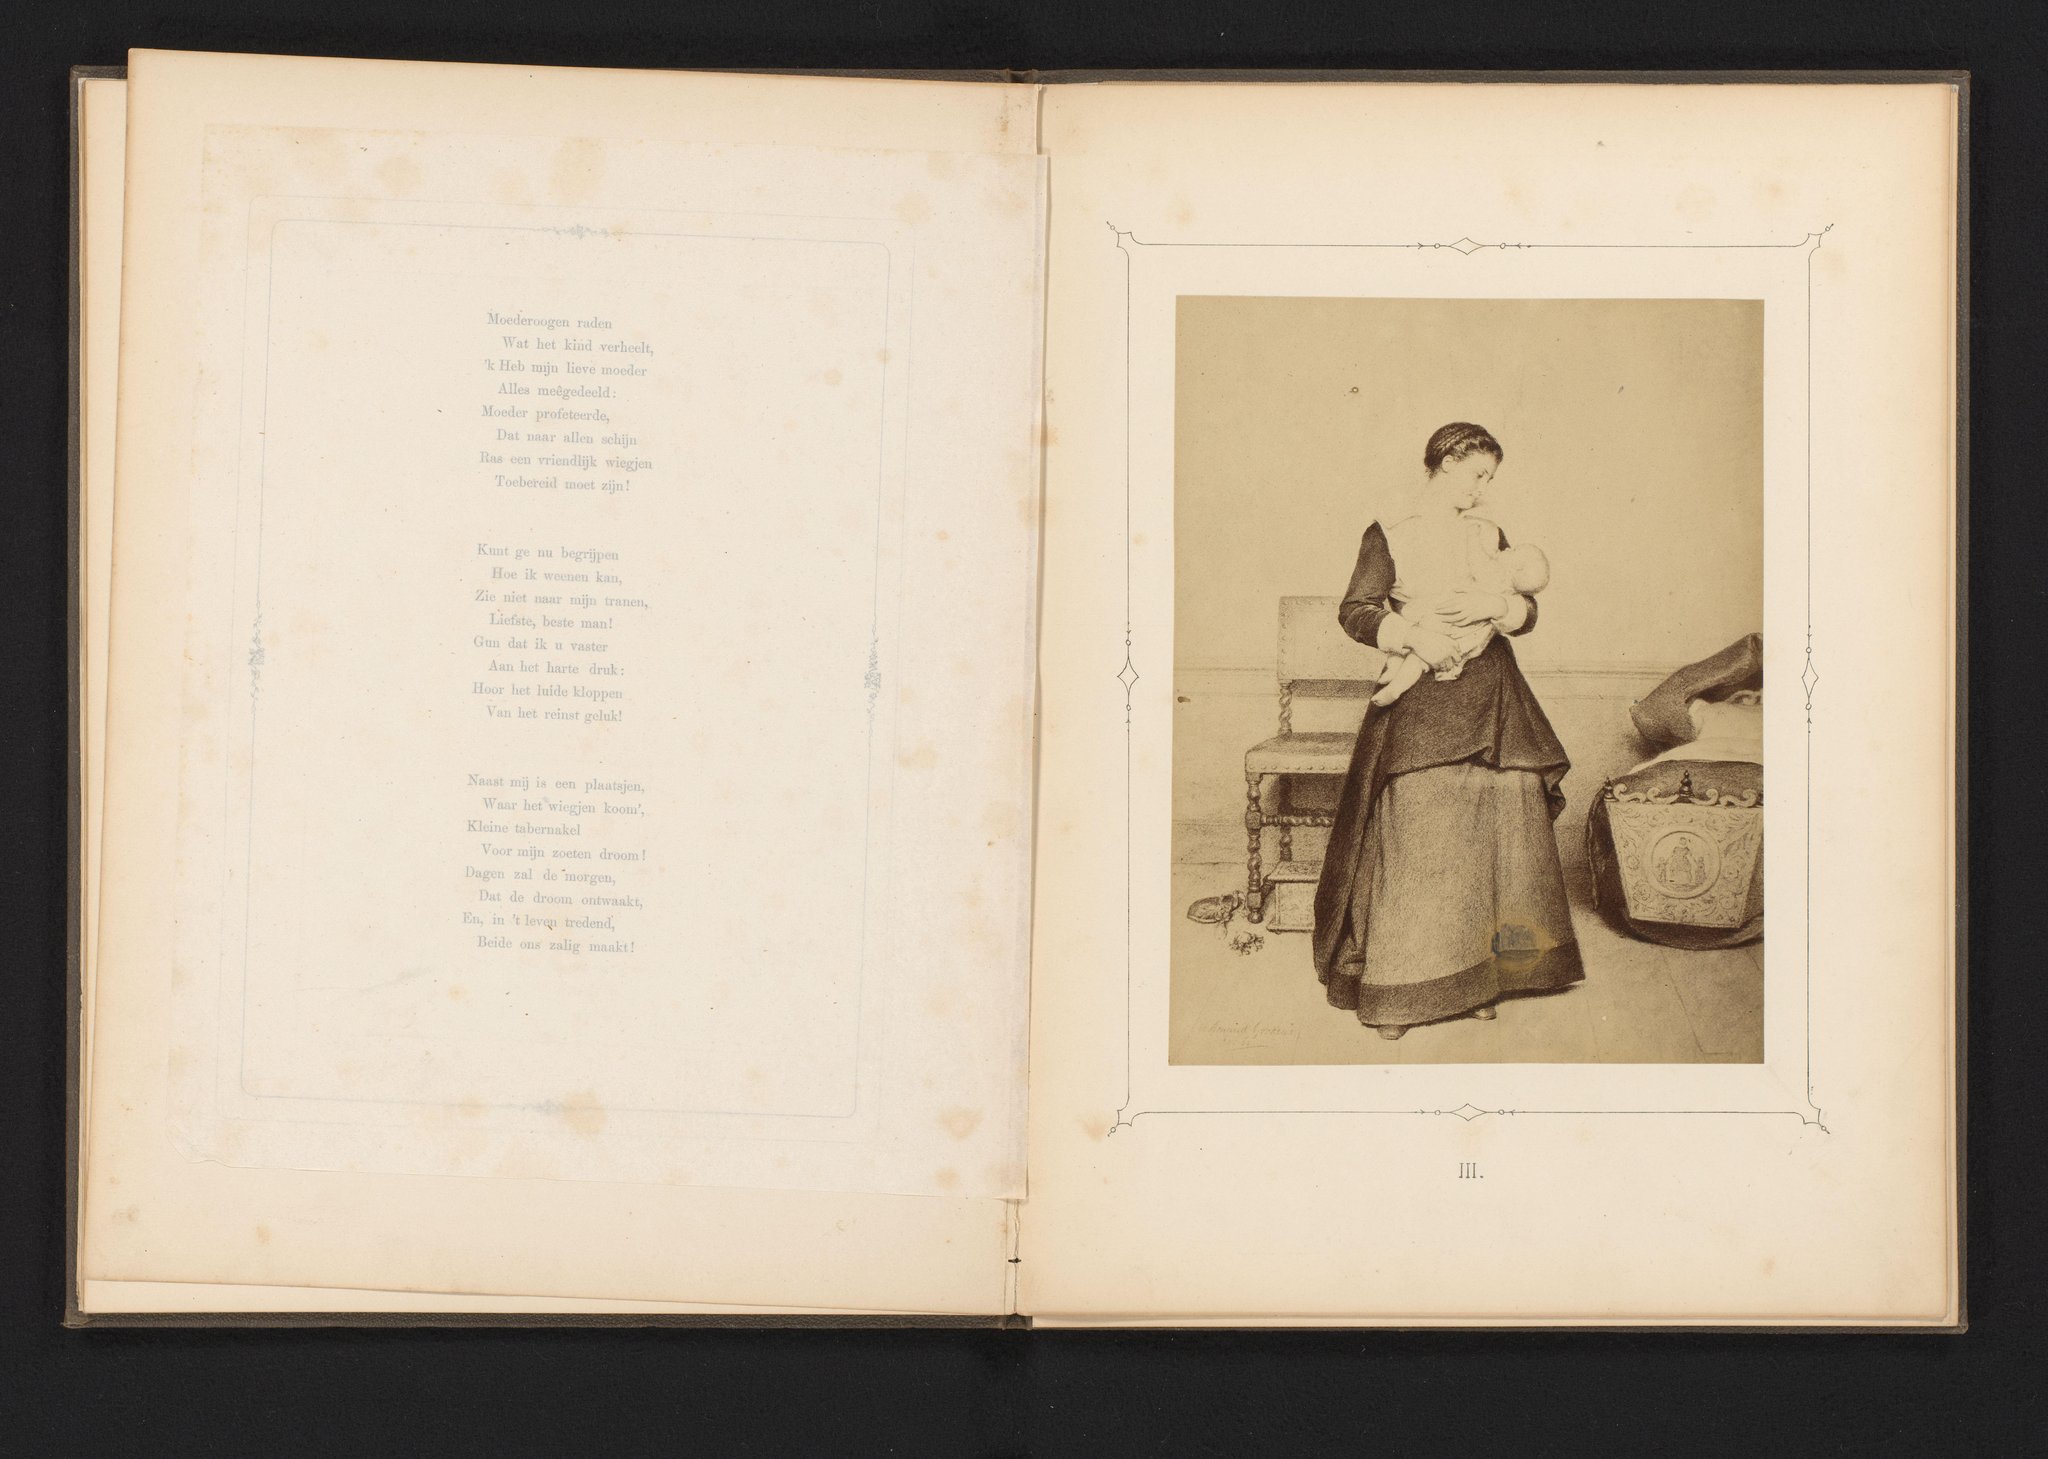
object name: page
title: Fotoreproductie van een tekening van een moeder met baby door Johannes Christiaan d'Arnaud Gerkens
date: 1858-1863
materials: paper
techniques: albumen print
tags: mother and baby or young child